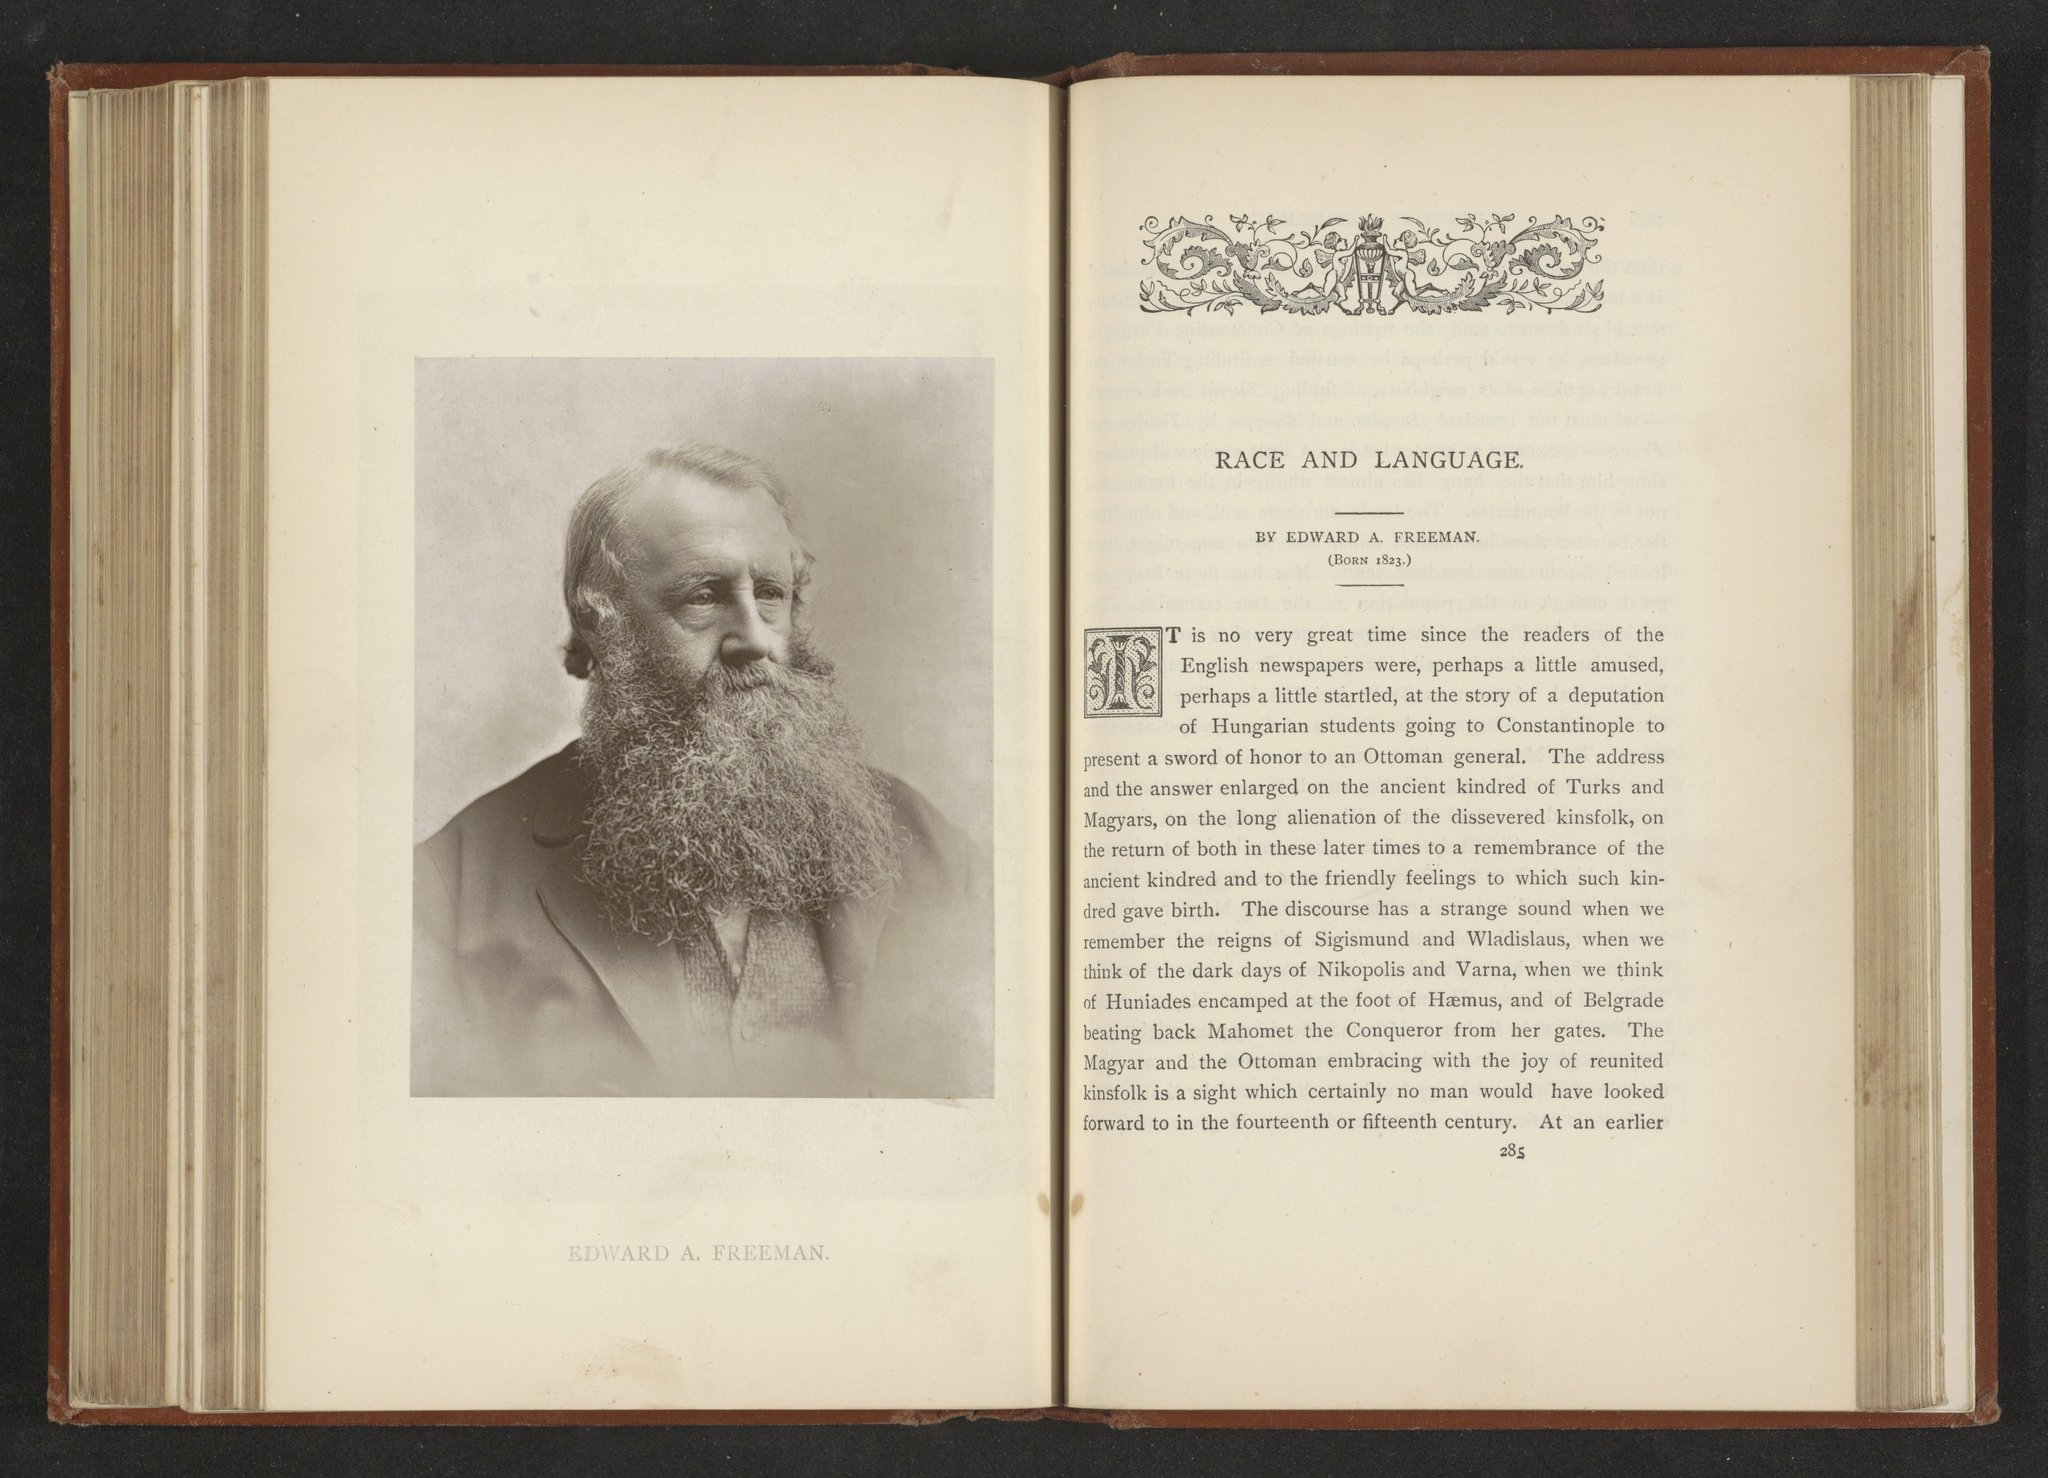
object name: page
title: Edward A. Freeman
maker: Anonymous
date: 1876-1886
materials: paper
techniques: woodburytype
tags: portrait of a writer